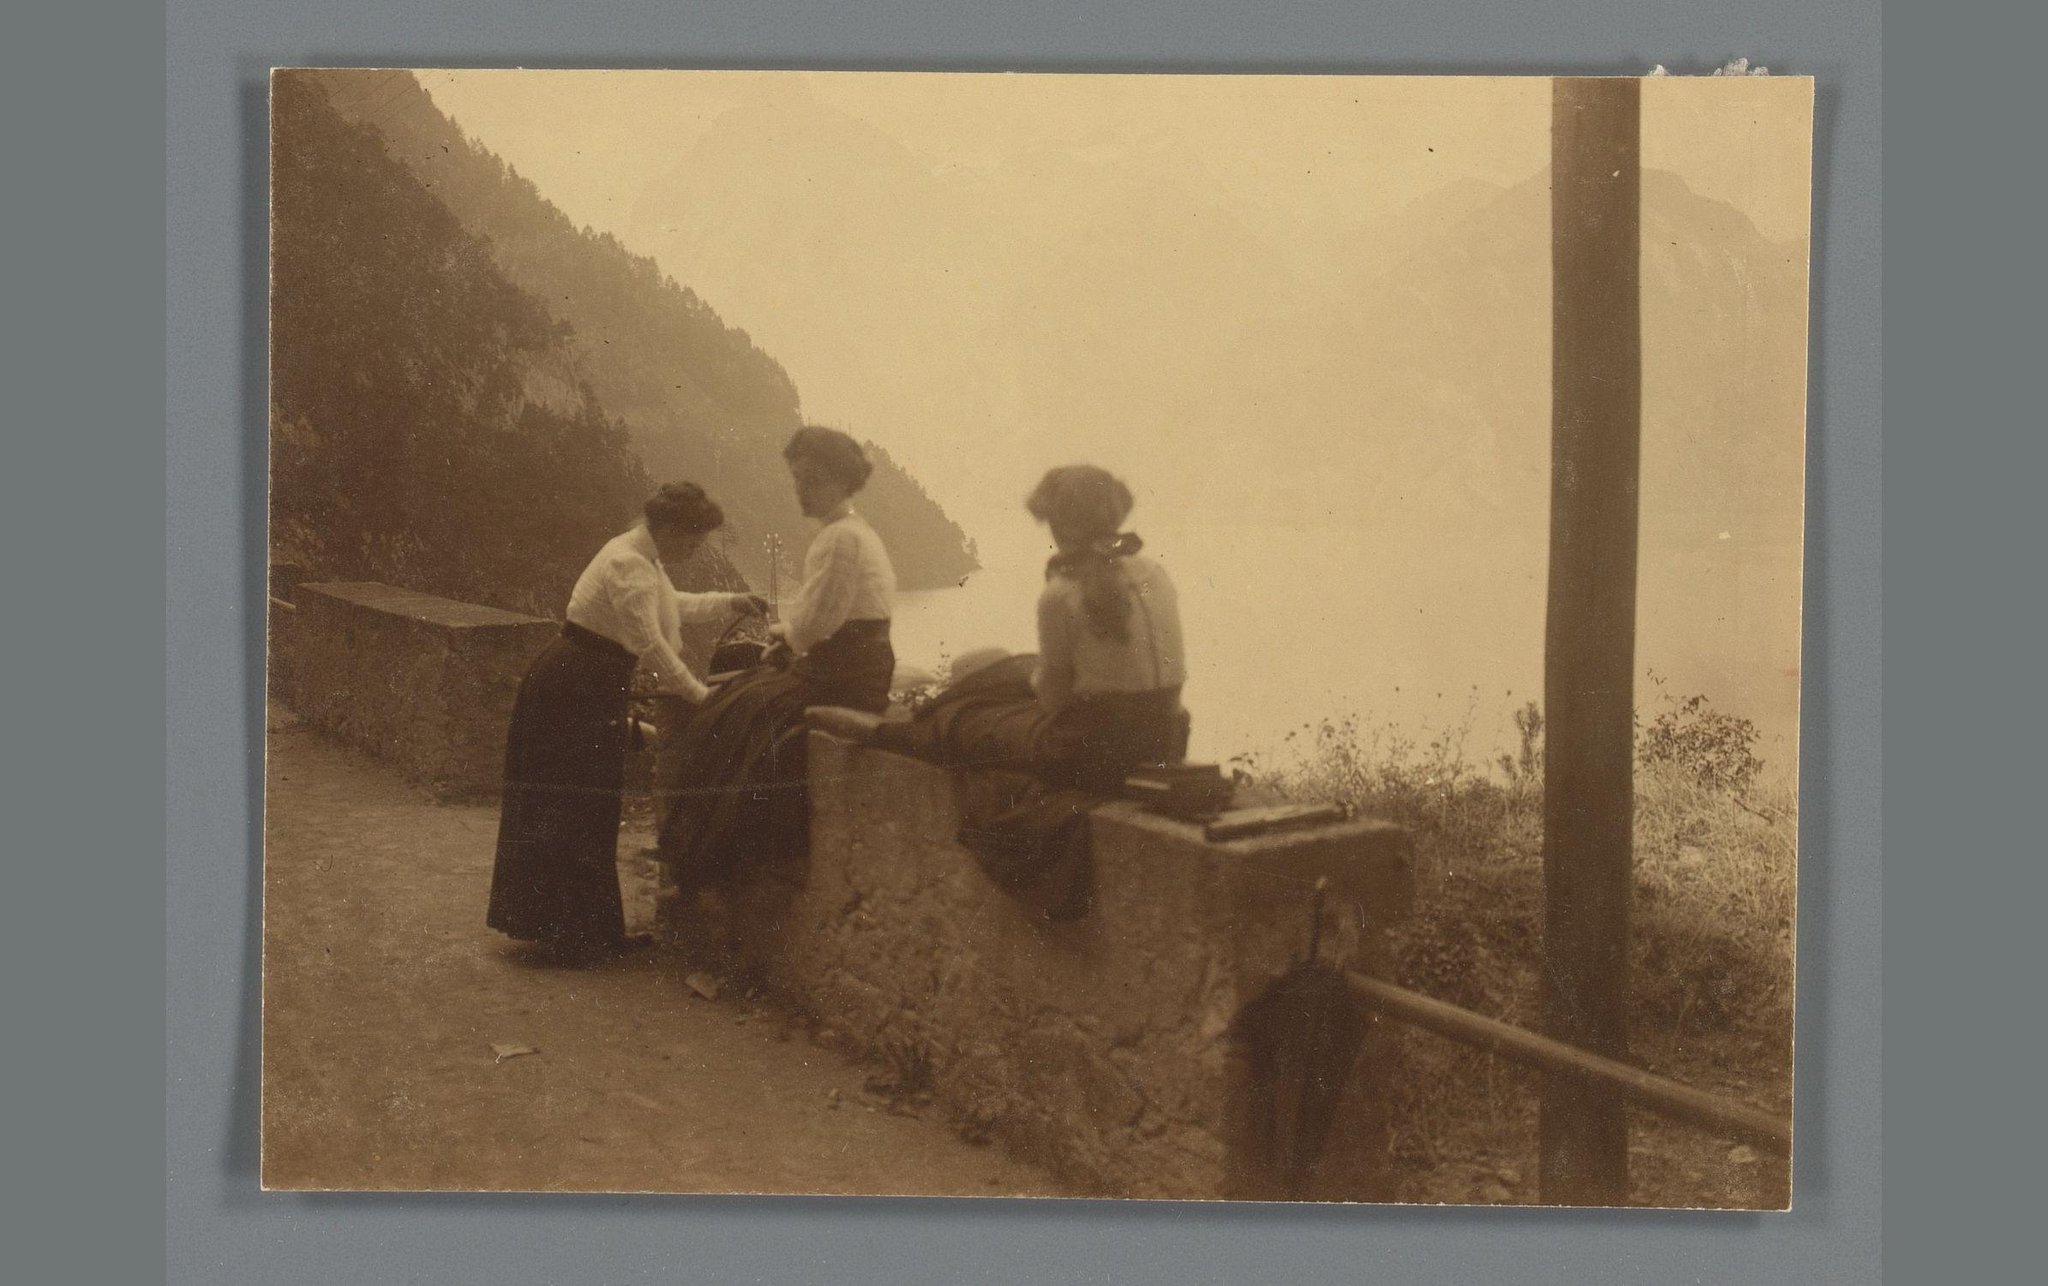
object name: photograph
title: Johanna (Hans) de Jong, Johanna (Nan) Vreede en Elisabeth de Jong in Kandersteg, Zwitserland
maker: willem de jong (fotograaf)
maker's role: arts, fotograaf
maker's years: 1864-1918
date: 1914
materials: paper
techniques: daylight paper print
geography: switzerland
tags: haarlem, elisabeth de jong-van tonderen, leiden, johanna petronella lambertina stokhuyzen-de jong (hans), surabaya, johanna elisabeth borgerhoff mulder-vreede (nan), river, resting - bb - out of doors, mountains